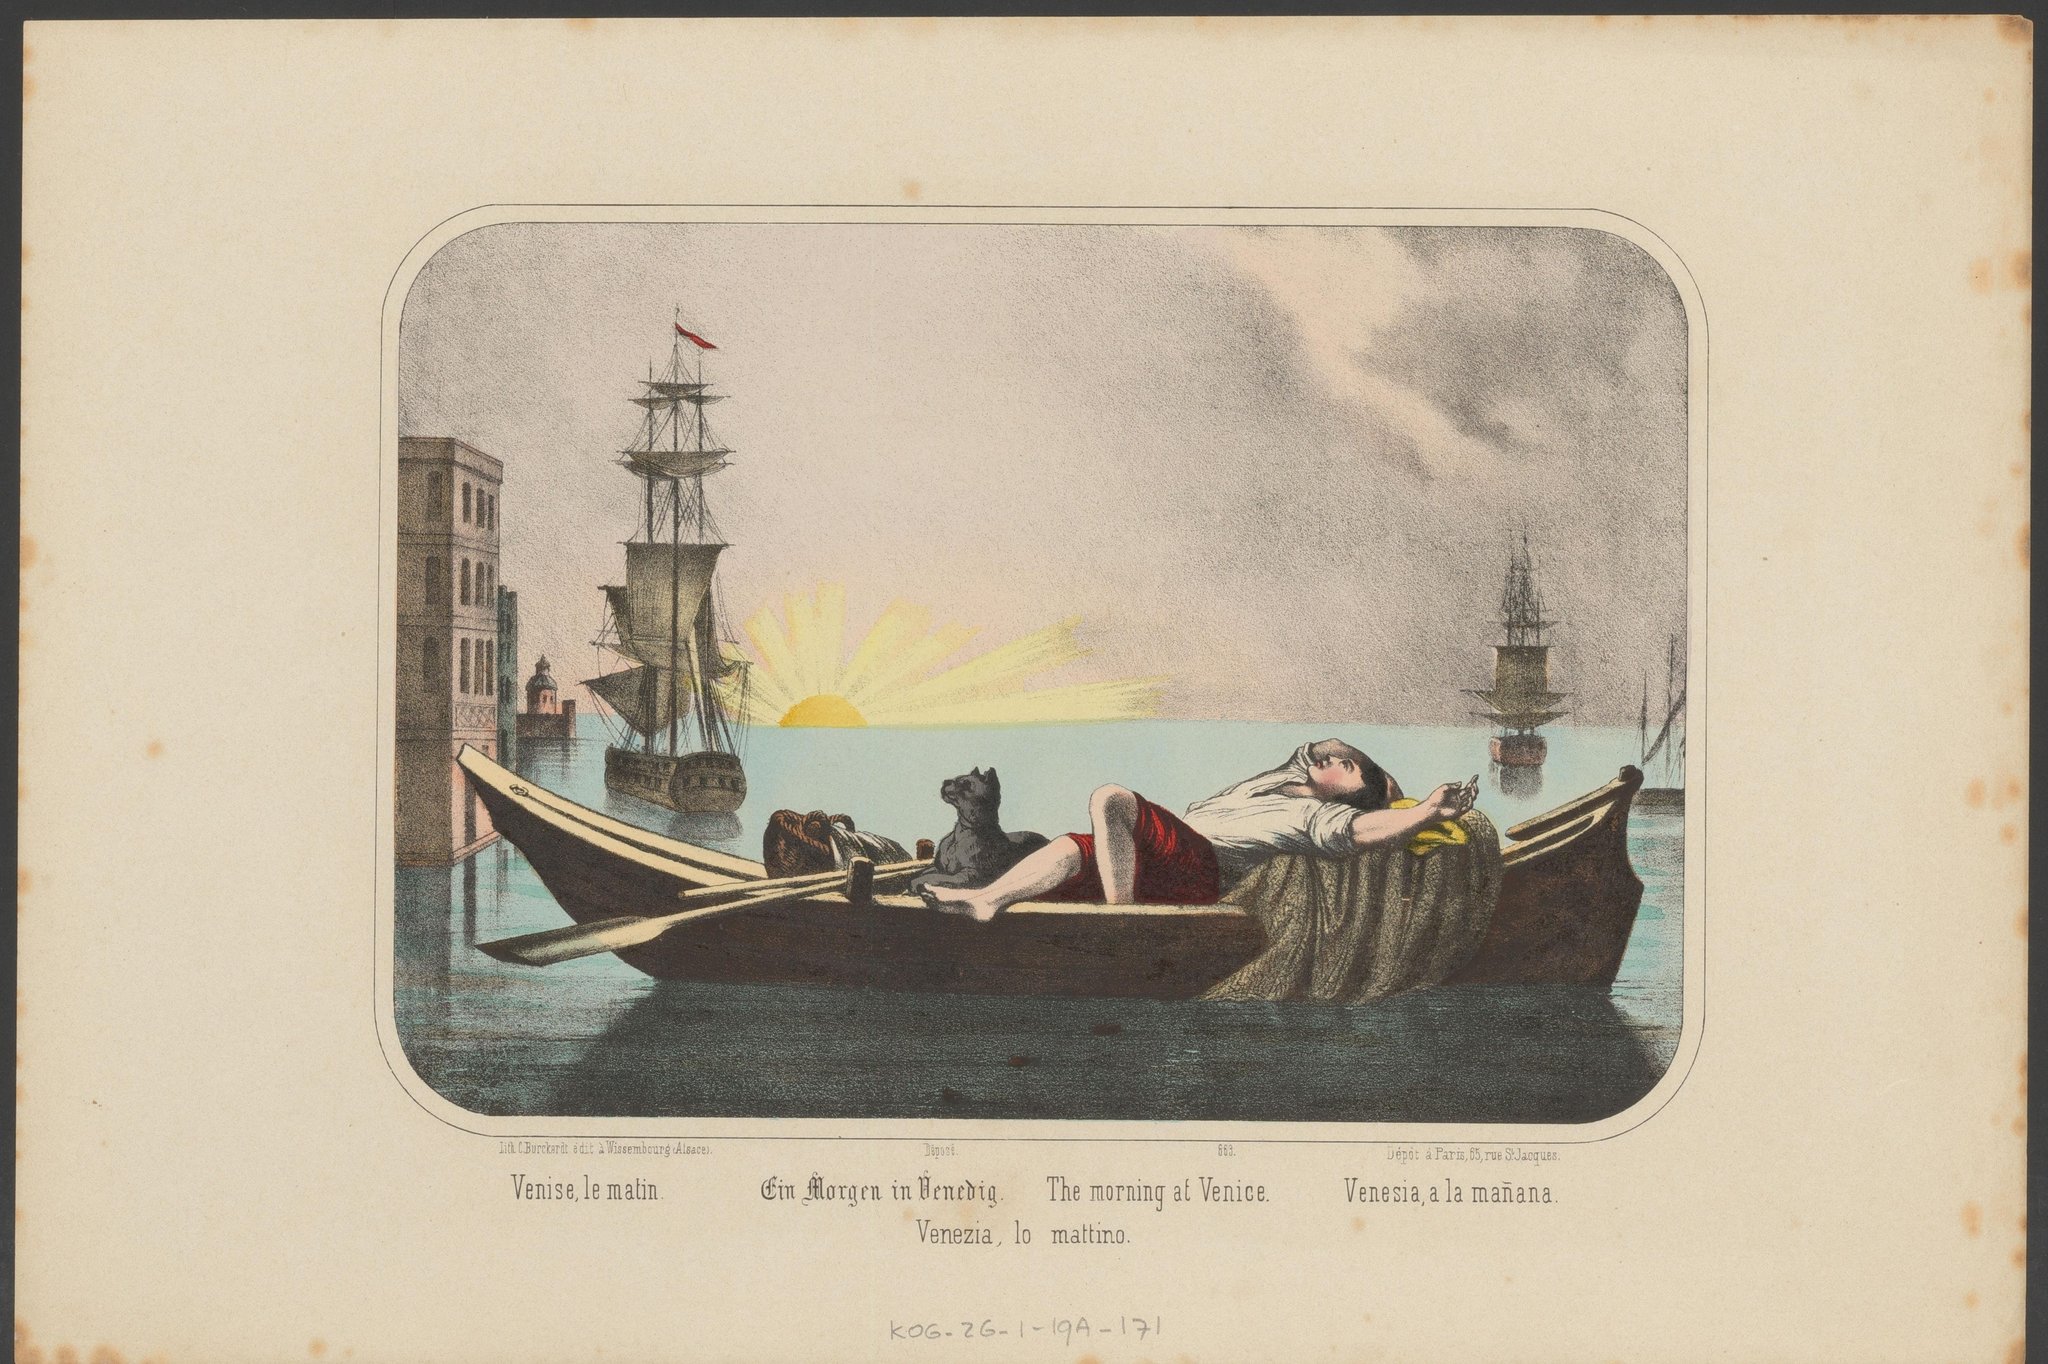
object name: print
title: Drie personen in een boot voor de Vesuvius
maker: charles burckhardt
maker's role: publisher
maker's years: -1889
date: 1870-1877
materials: paper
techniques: hand coloring, lithograph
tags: rowing-boat, canoe, etc., sunrise, venice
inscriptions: stamp: Lugt 2233, : ‘Déposé’, collector's mark: Lugt 1641, stamp:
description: Onderaan genummerd: 663. Onderwerpsrubrieken binnen de Atlas Zeden en Gewoonten: Zeden en Gewoonten in Engeren Zin, Des menschen beging, midden en einde, Kinderleven – Kinderspel en Kinderprenten.